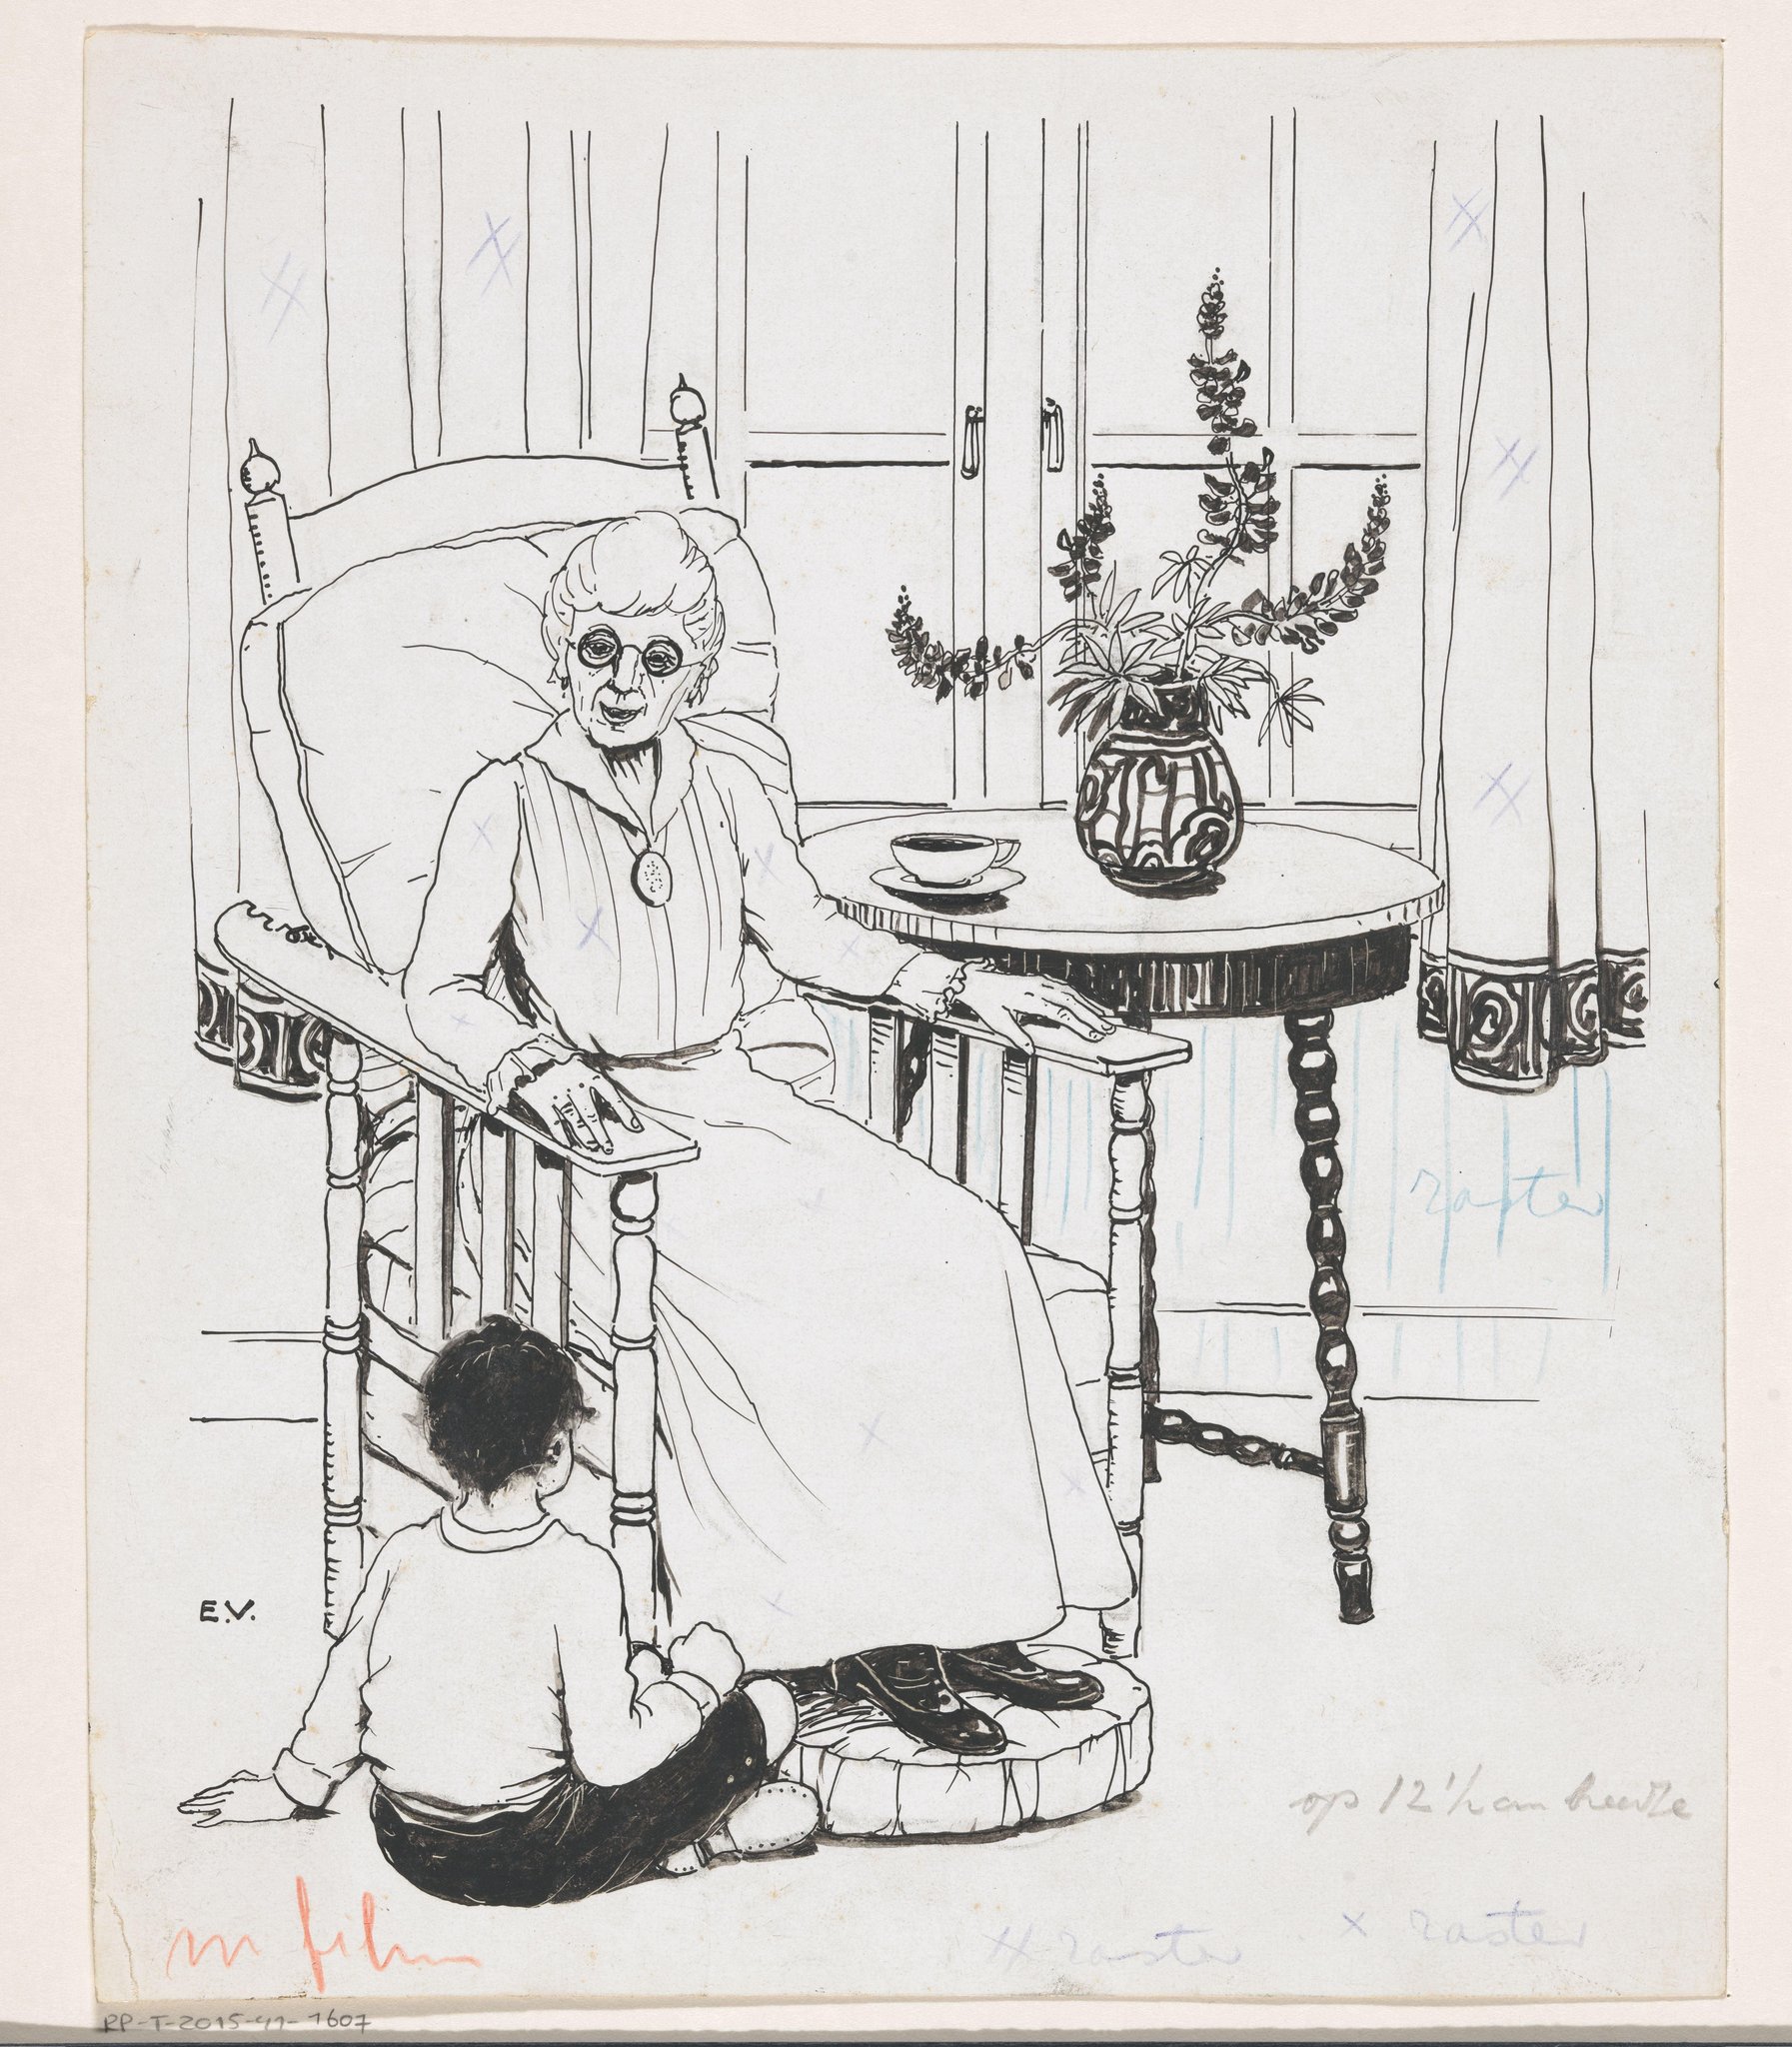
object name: drawing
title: Zittende jongen bij oude vrouw in leunstoel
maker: elly verstijnen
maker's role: draughtsman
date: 1900-1930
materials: ink, paper, pencil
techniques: brush, pen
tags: sitting figure (+ old female (human being))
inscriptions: signature: ‘E.V.’, :, collector's mark: Lugt 2228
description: In een kamer zit een oude vrouw in een leunstoel. Op de tafel naast haar staat een kop thee of koffie. Op de grond bij haar stoel zit een jongen in kleermakerszit.